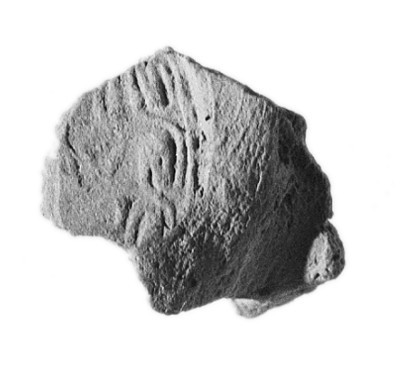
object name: sealing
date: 1981-1640 BCE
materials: mud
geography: egypt